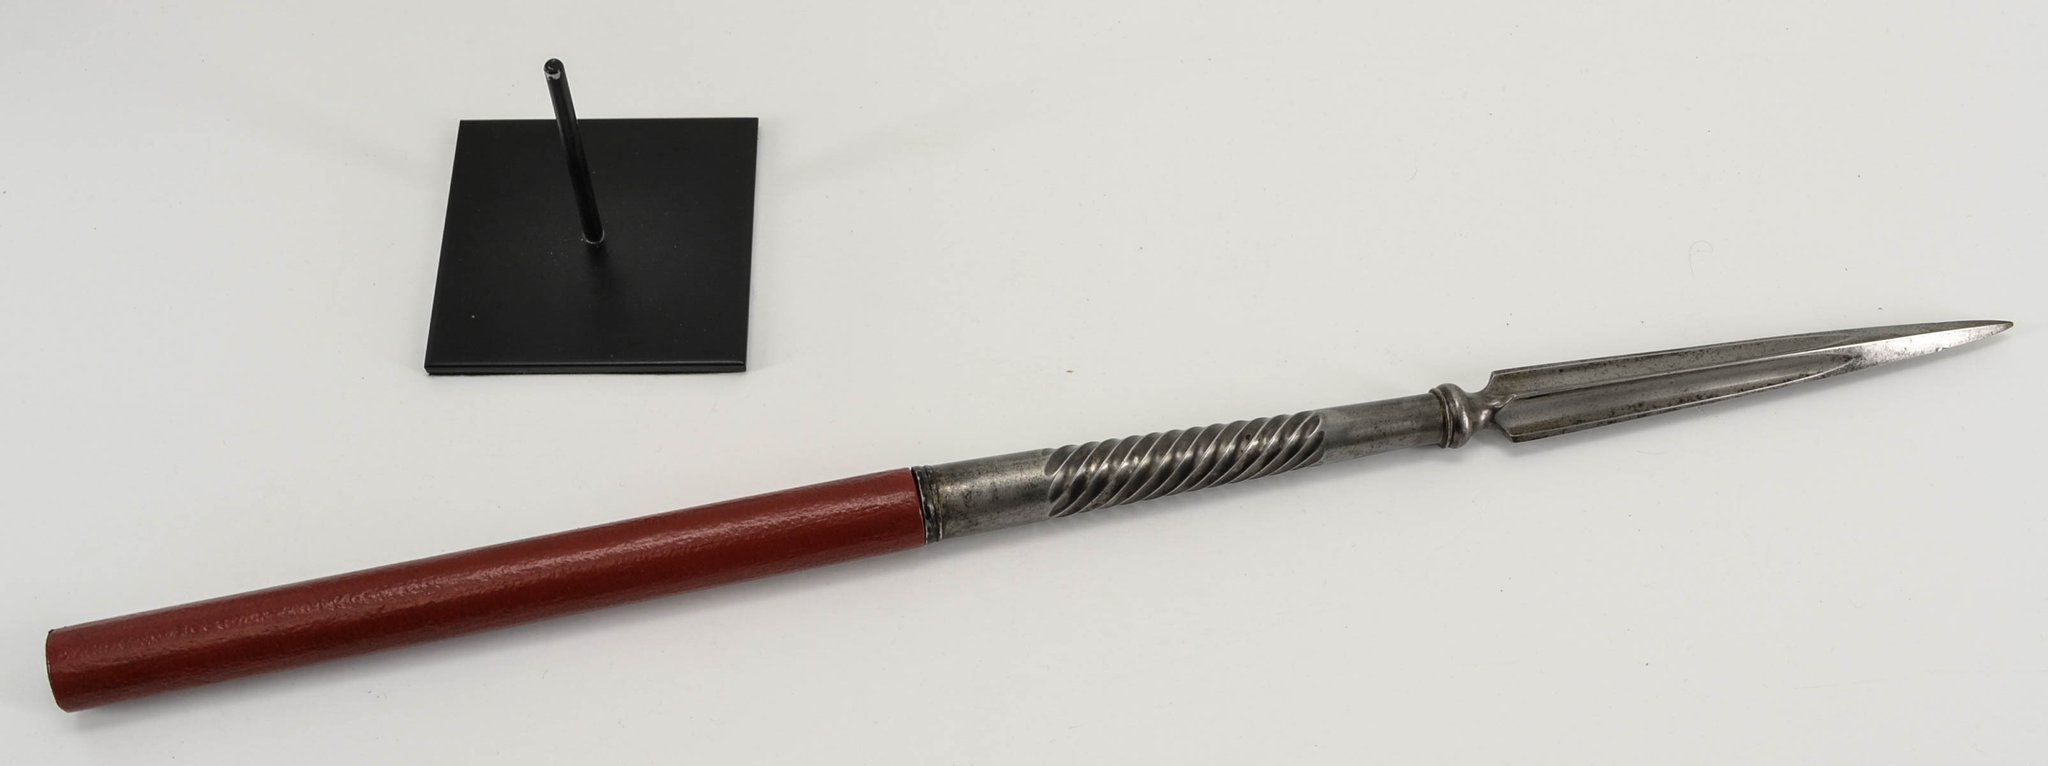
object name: spear head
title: Twisted Spear Head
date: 1601-1700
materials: steel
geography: india